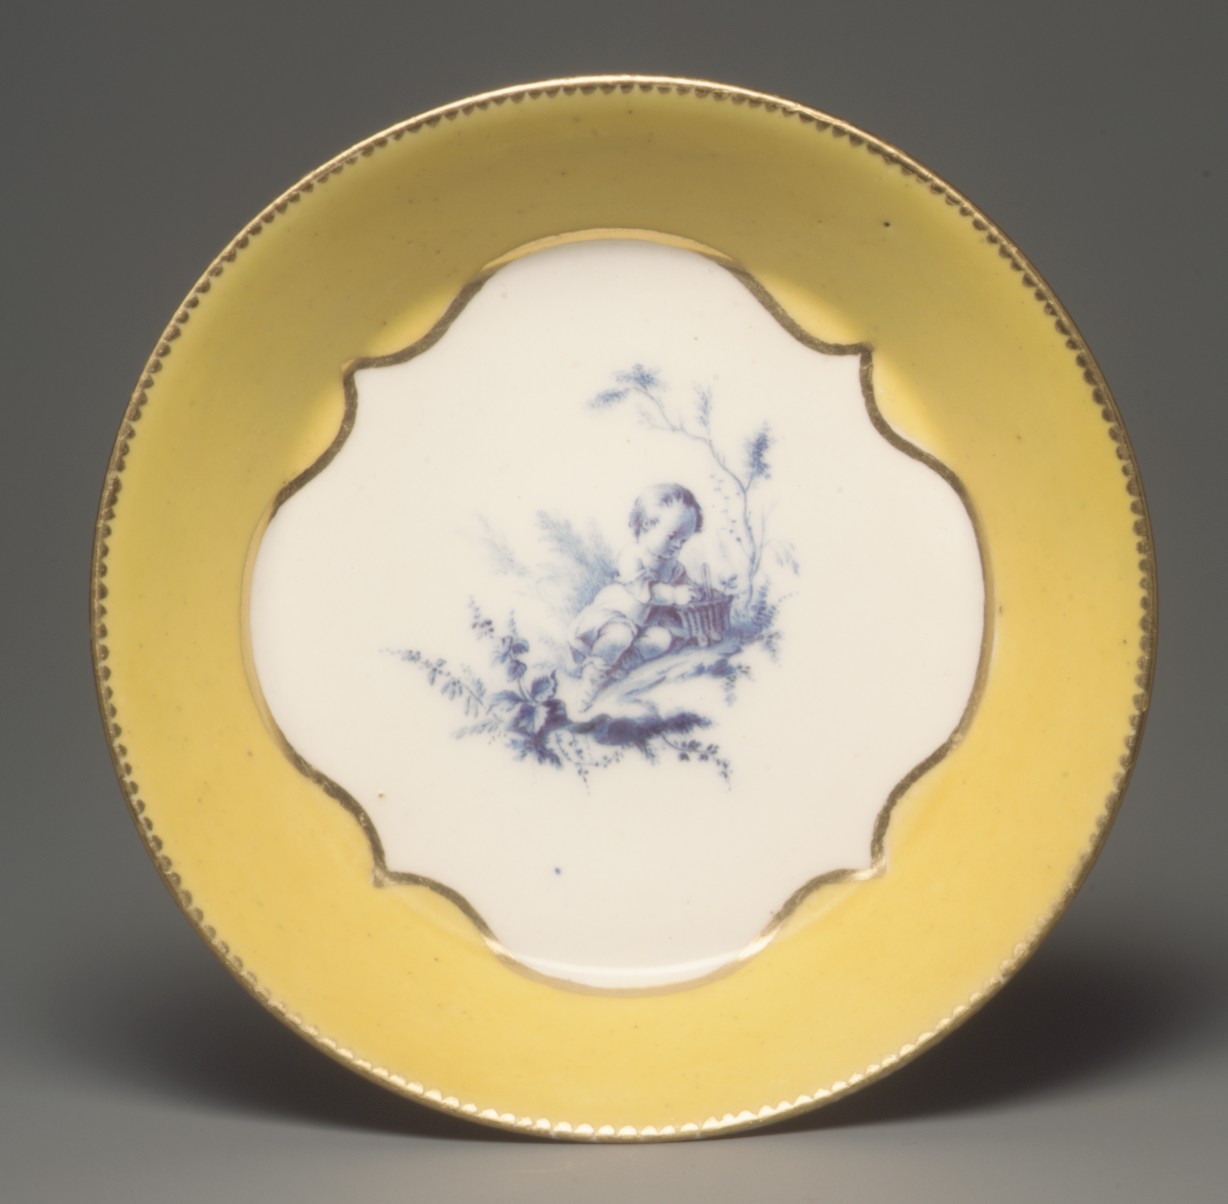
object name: saucer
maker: vincennes manufactory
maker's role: manufactory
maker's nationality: french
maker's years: 1740-1756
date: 1752-1753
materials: soft paste porcelain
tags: children